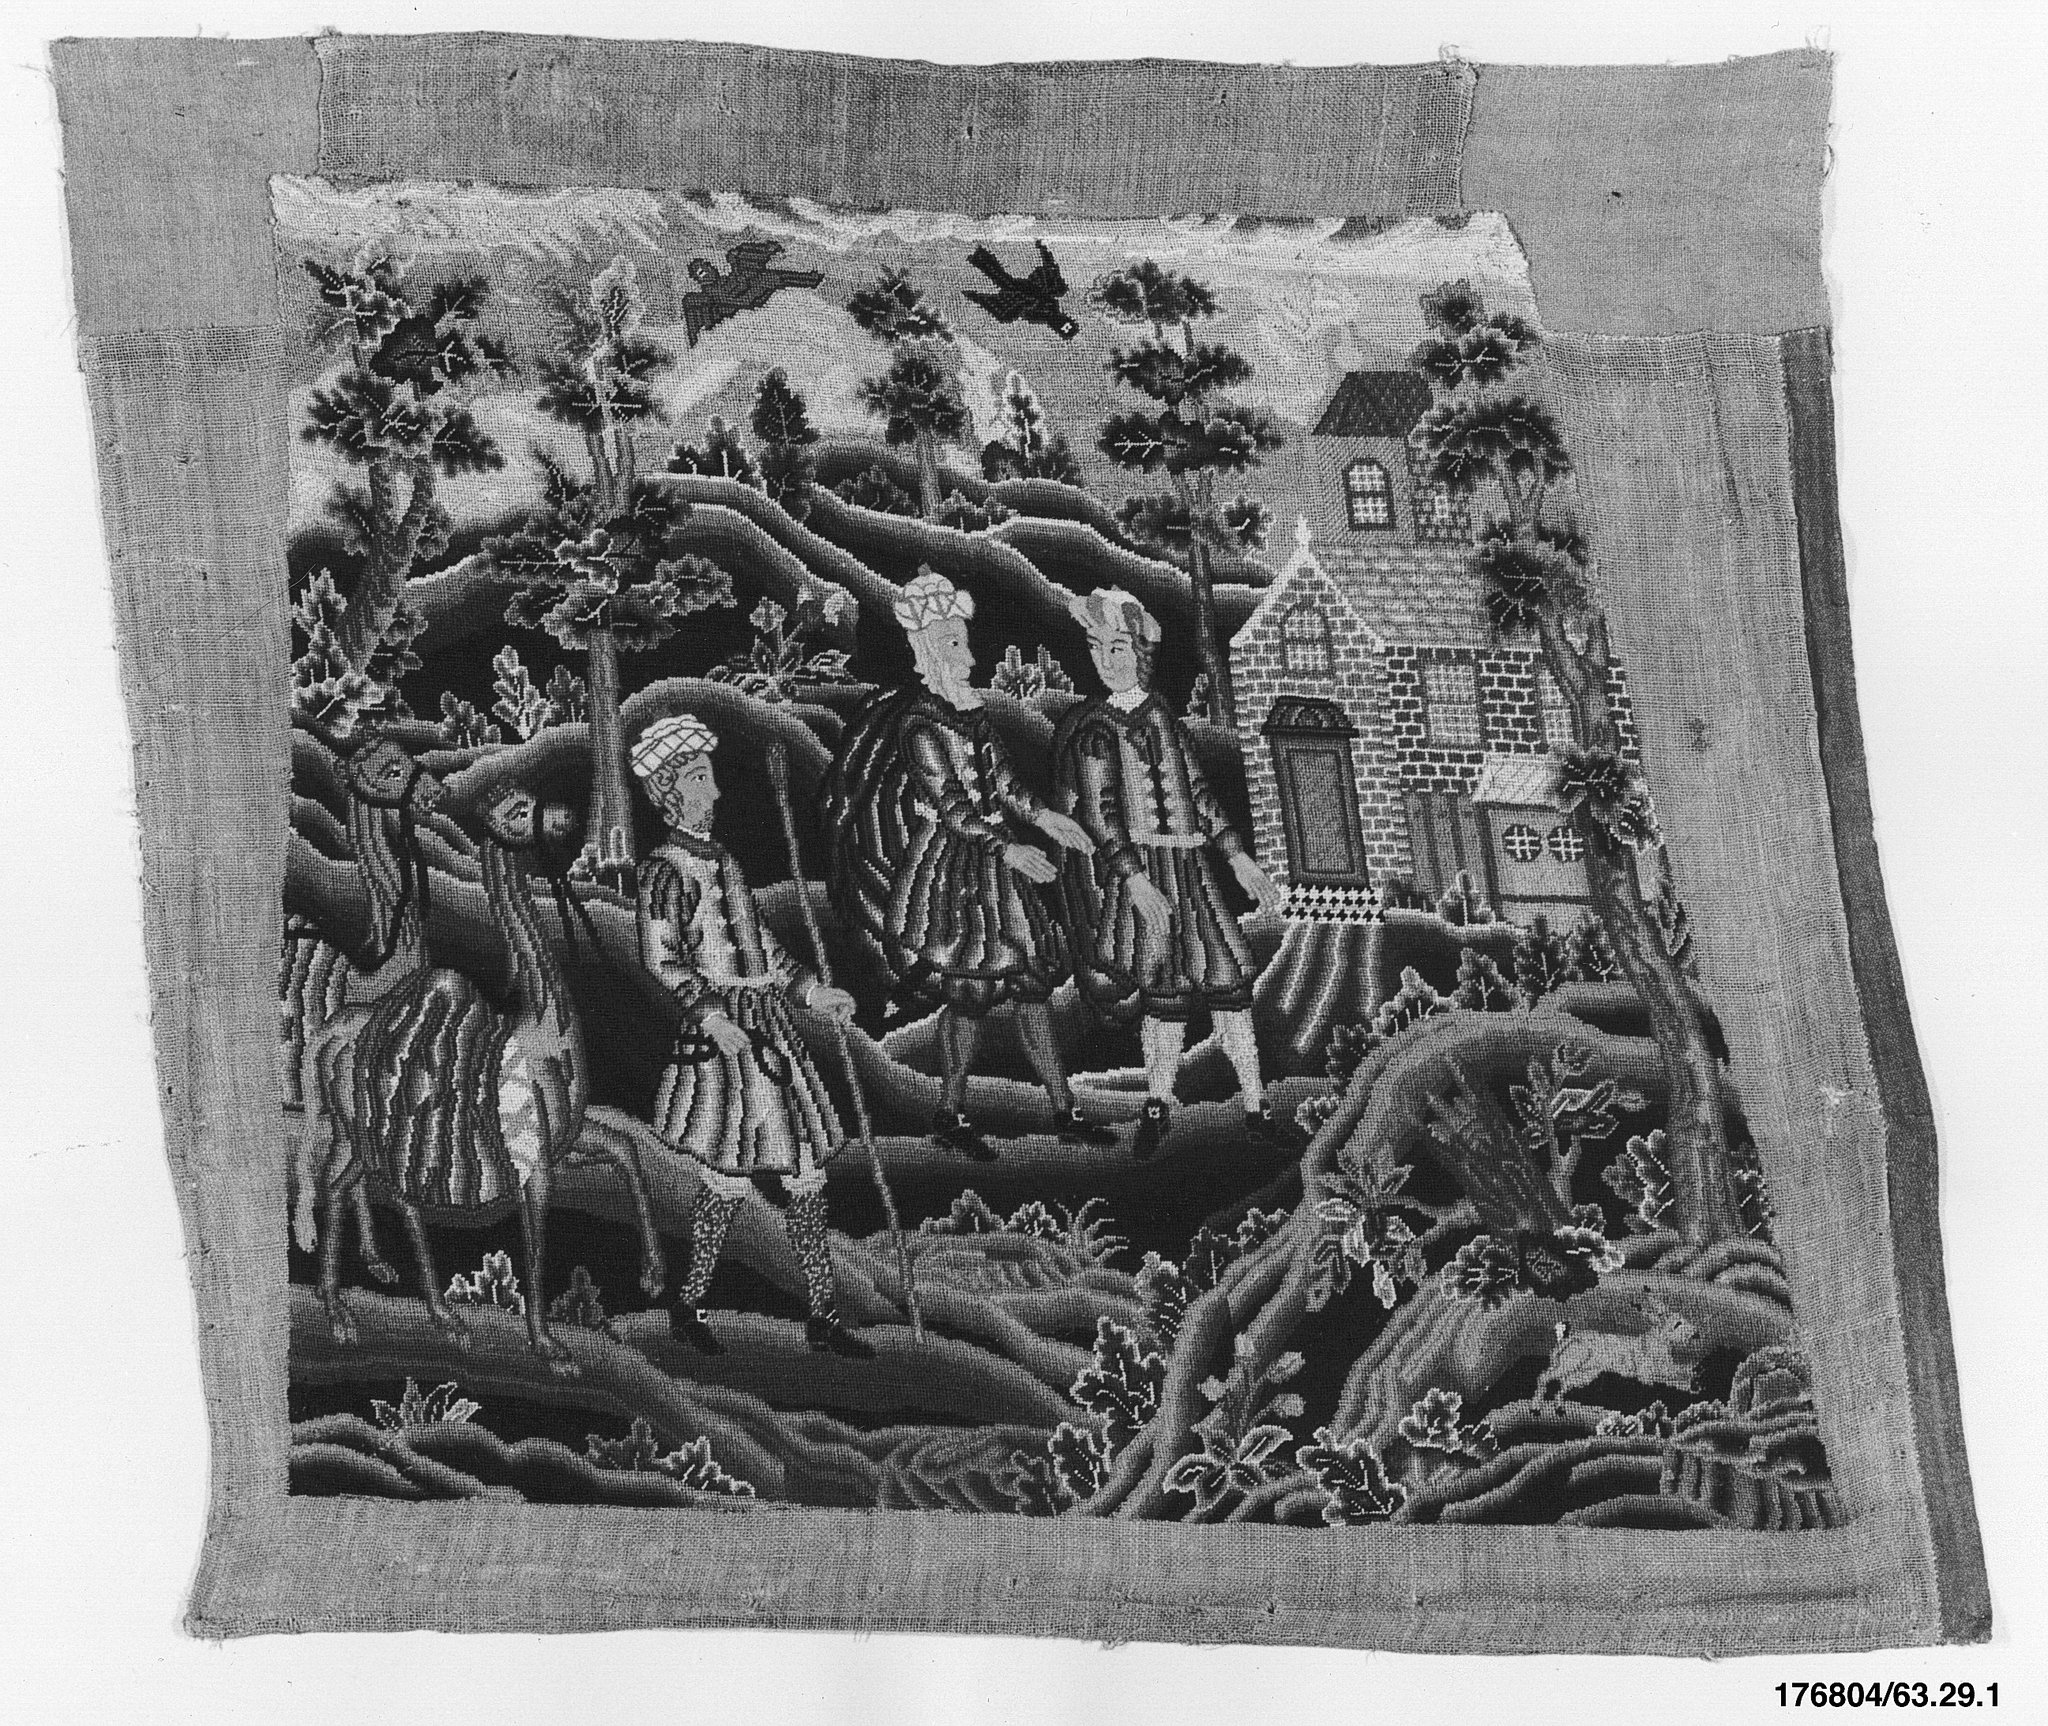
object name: chair cover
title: Six chair seat covers with the story of Rebecca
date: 1701-1733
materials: silk, wool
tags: houses,men,camels,trees